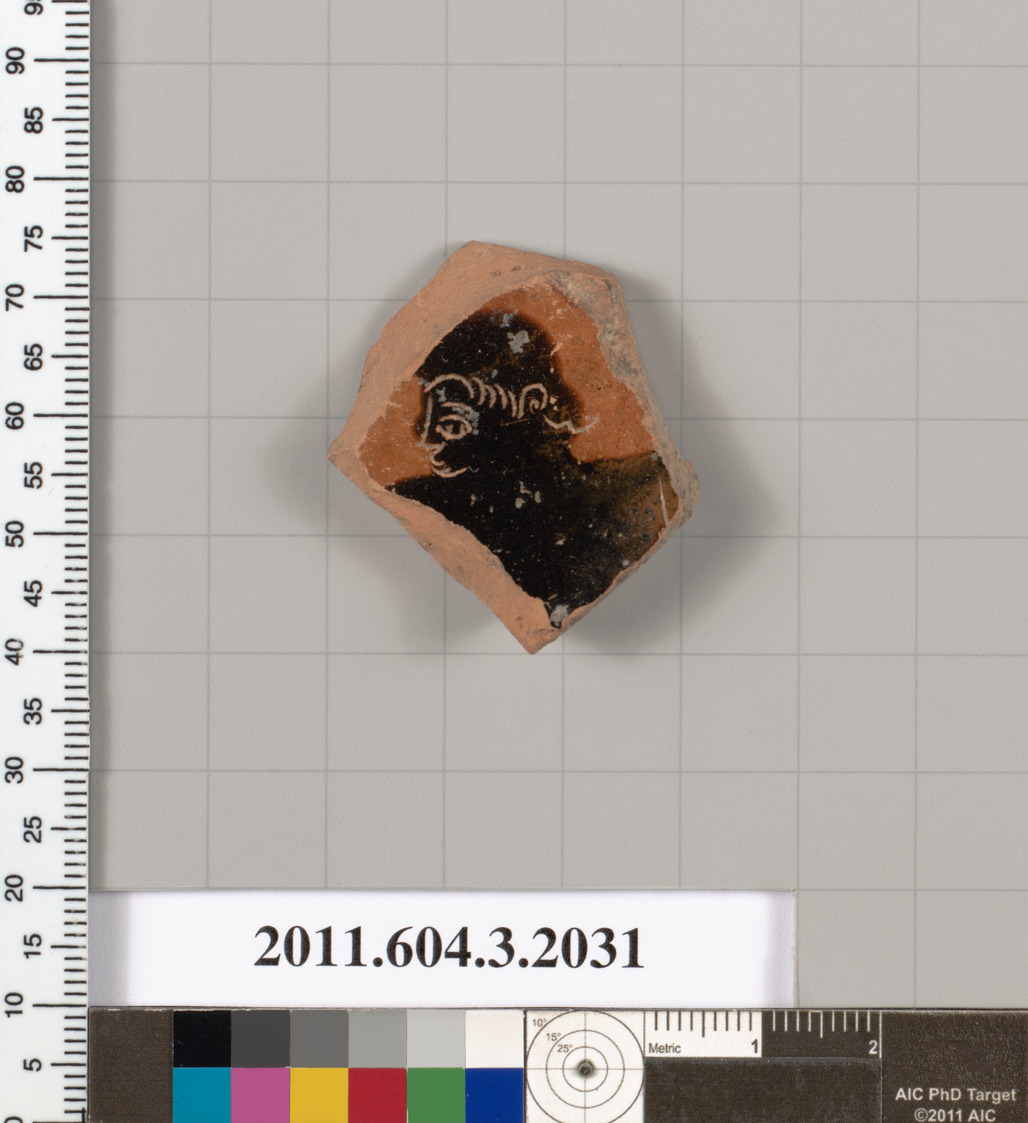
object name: kylix fragment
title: Terracotta fragment of a kylix (drinking cup)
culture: greek, attic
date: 534-468 BCE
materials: terracotta